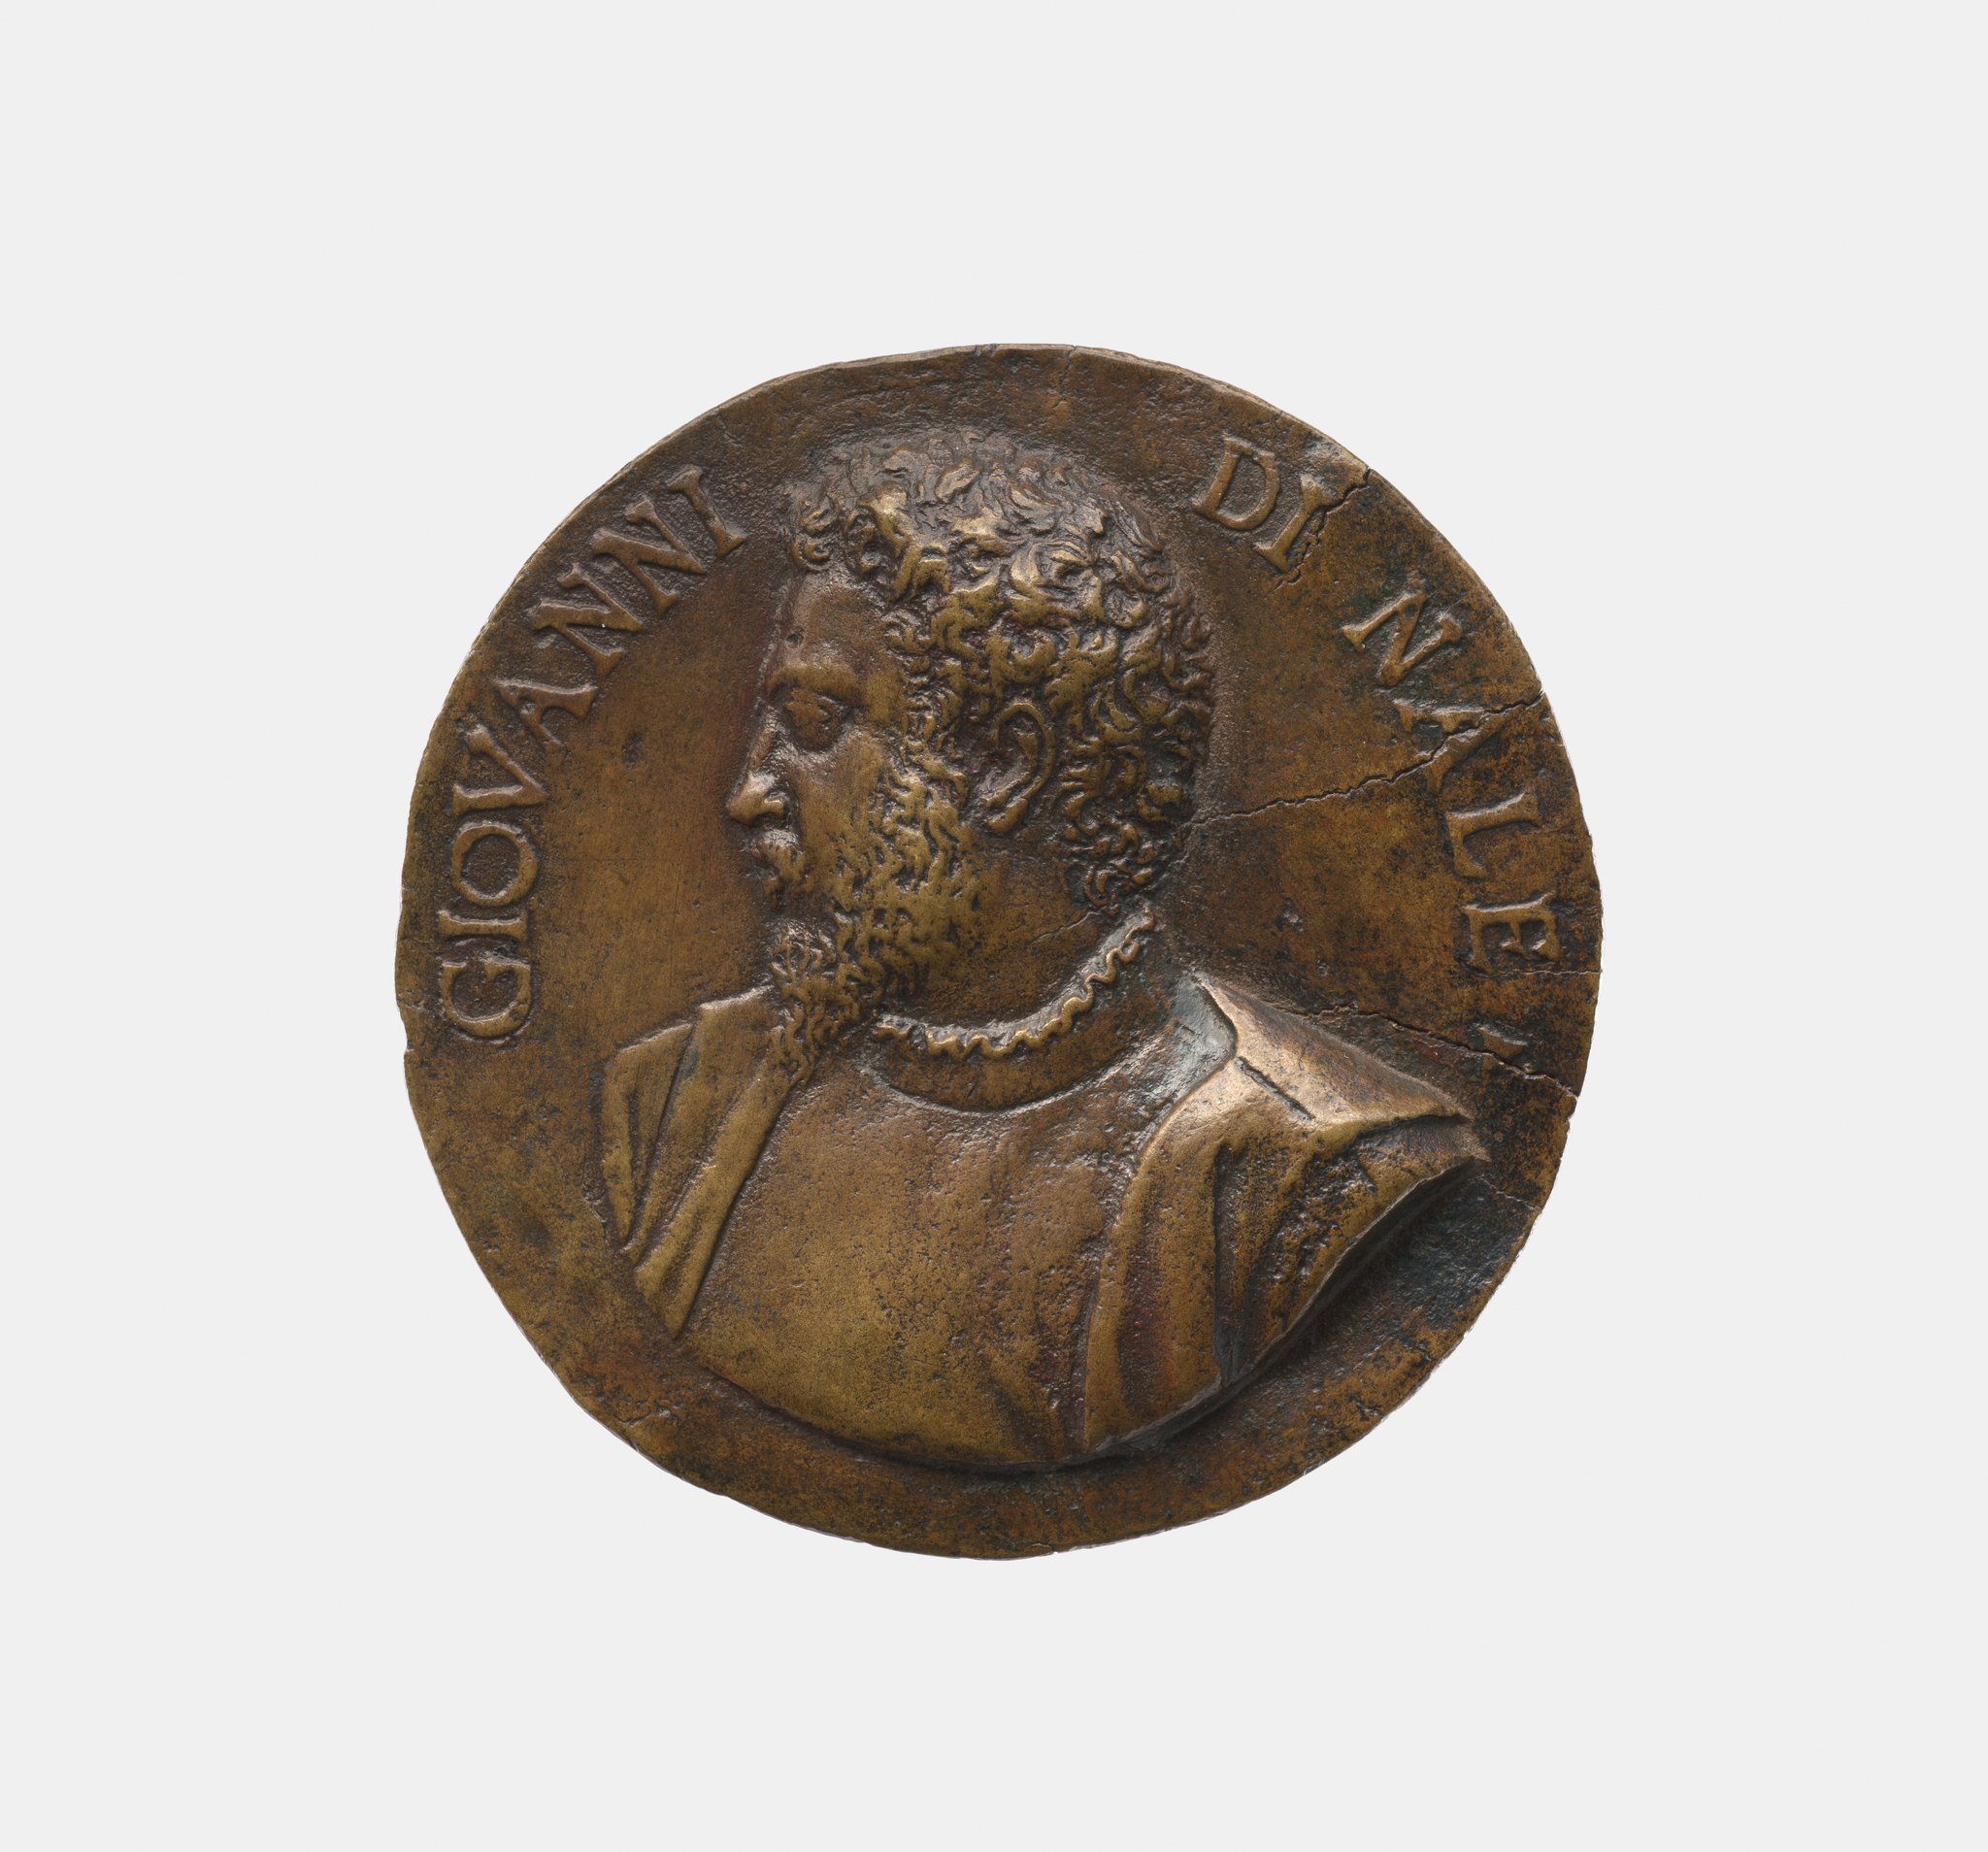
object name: medal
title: Giovanni di Nale b. 151 1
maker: Anonymous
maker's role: artist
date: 1544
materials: bronze